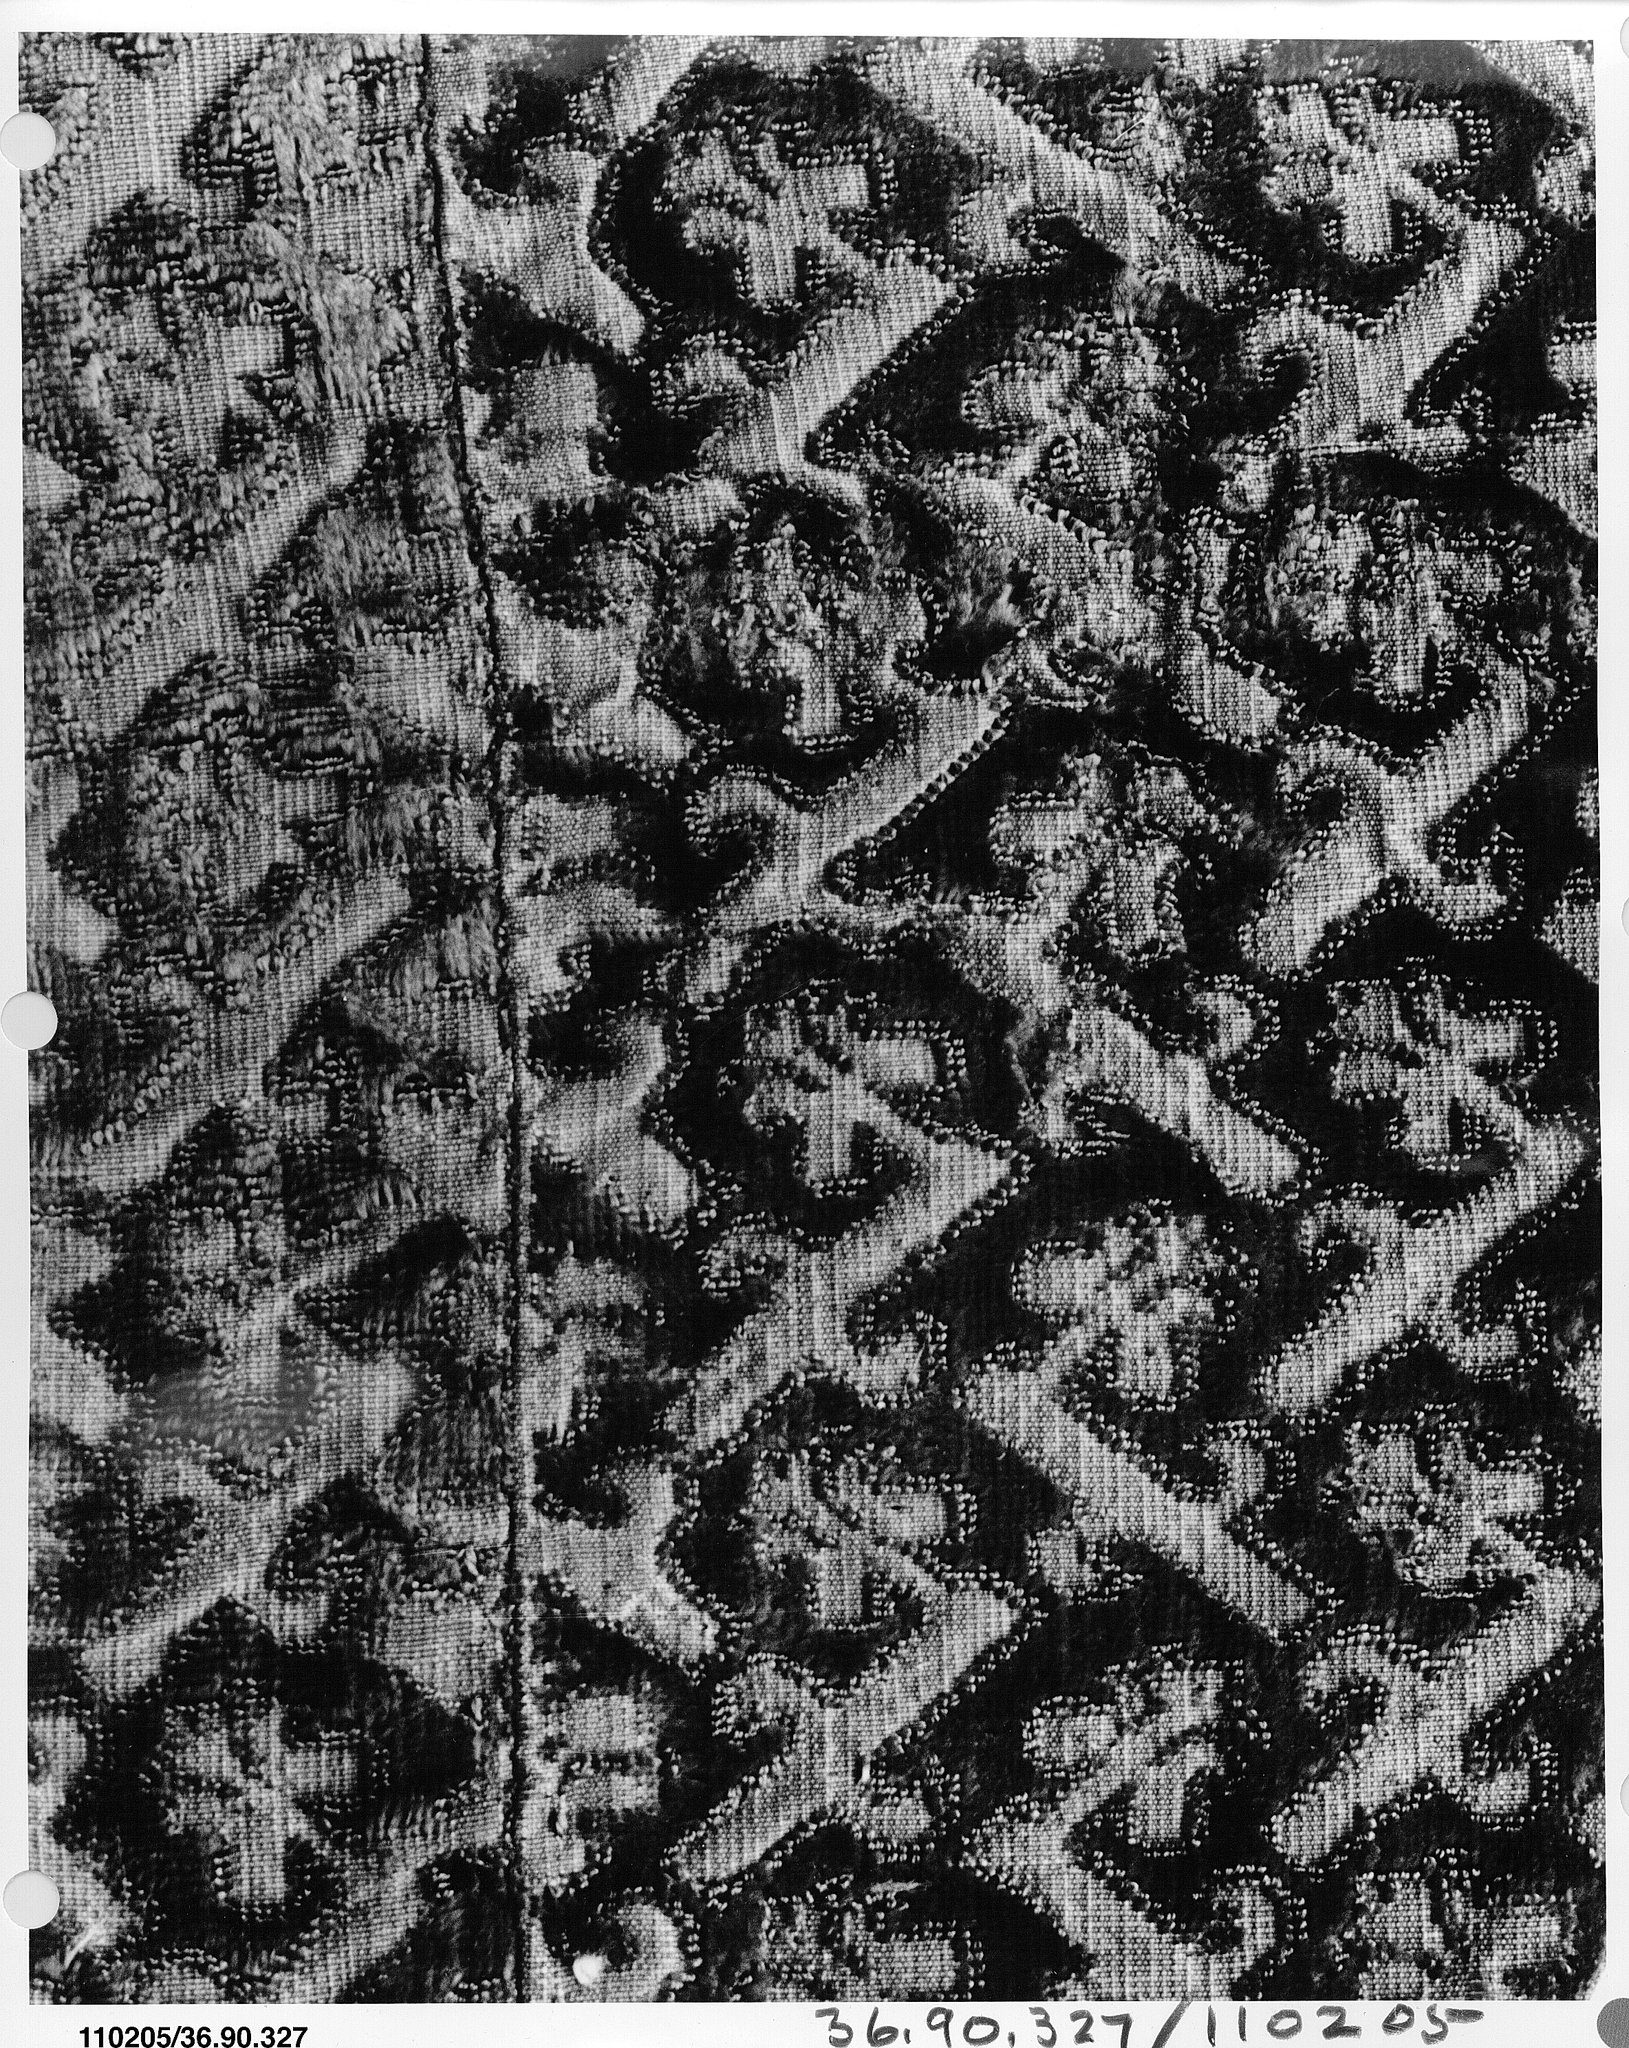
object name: piece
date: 1501-1700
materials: silk